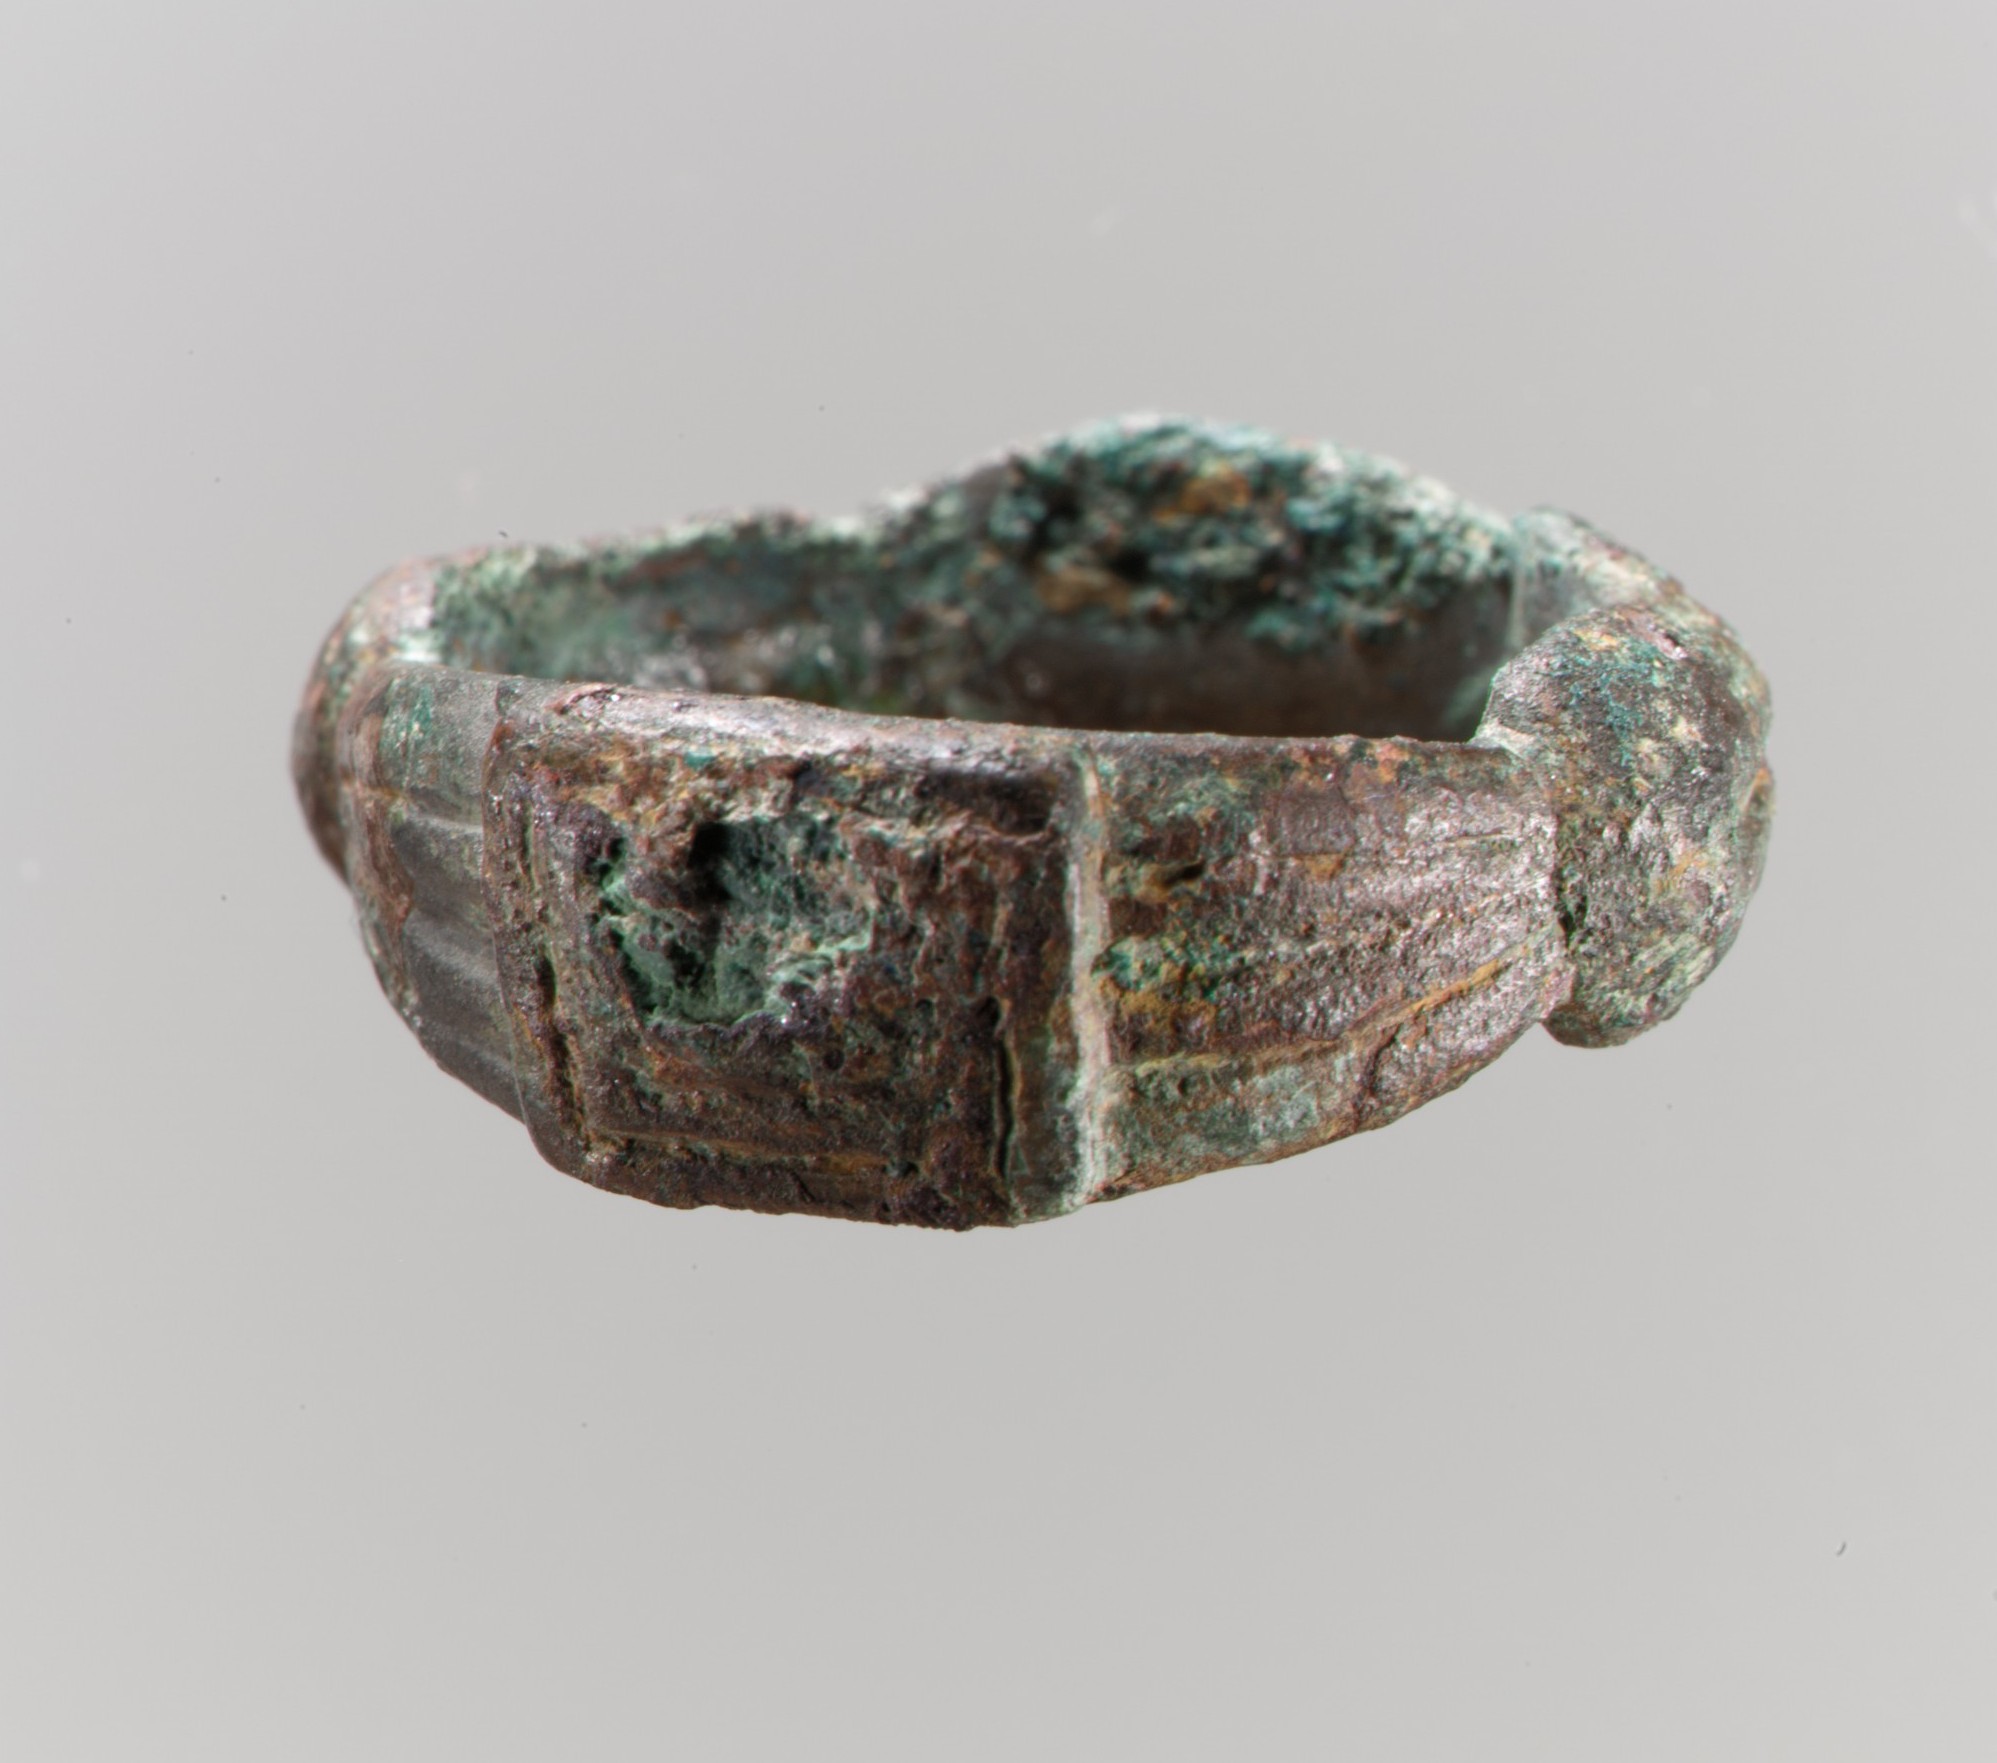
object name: ring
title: Finger Ring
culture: frankish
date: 567-633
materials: copper alloy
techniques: casting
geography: germany